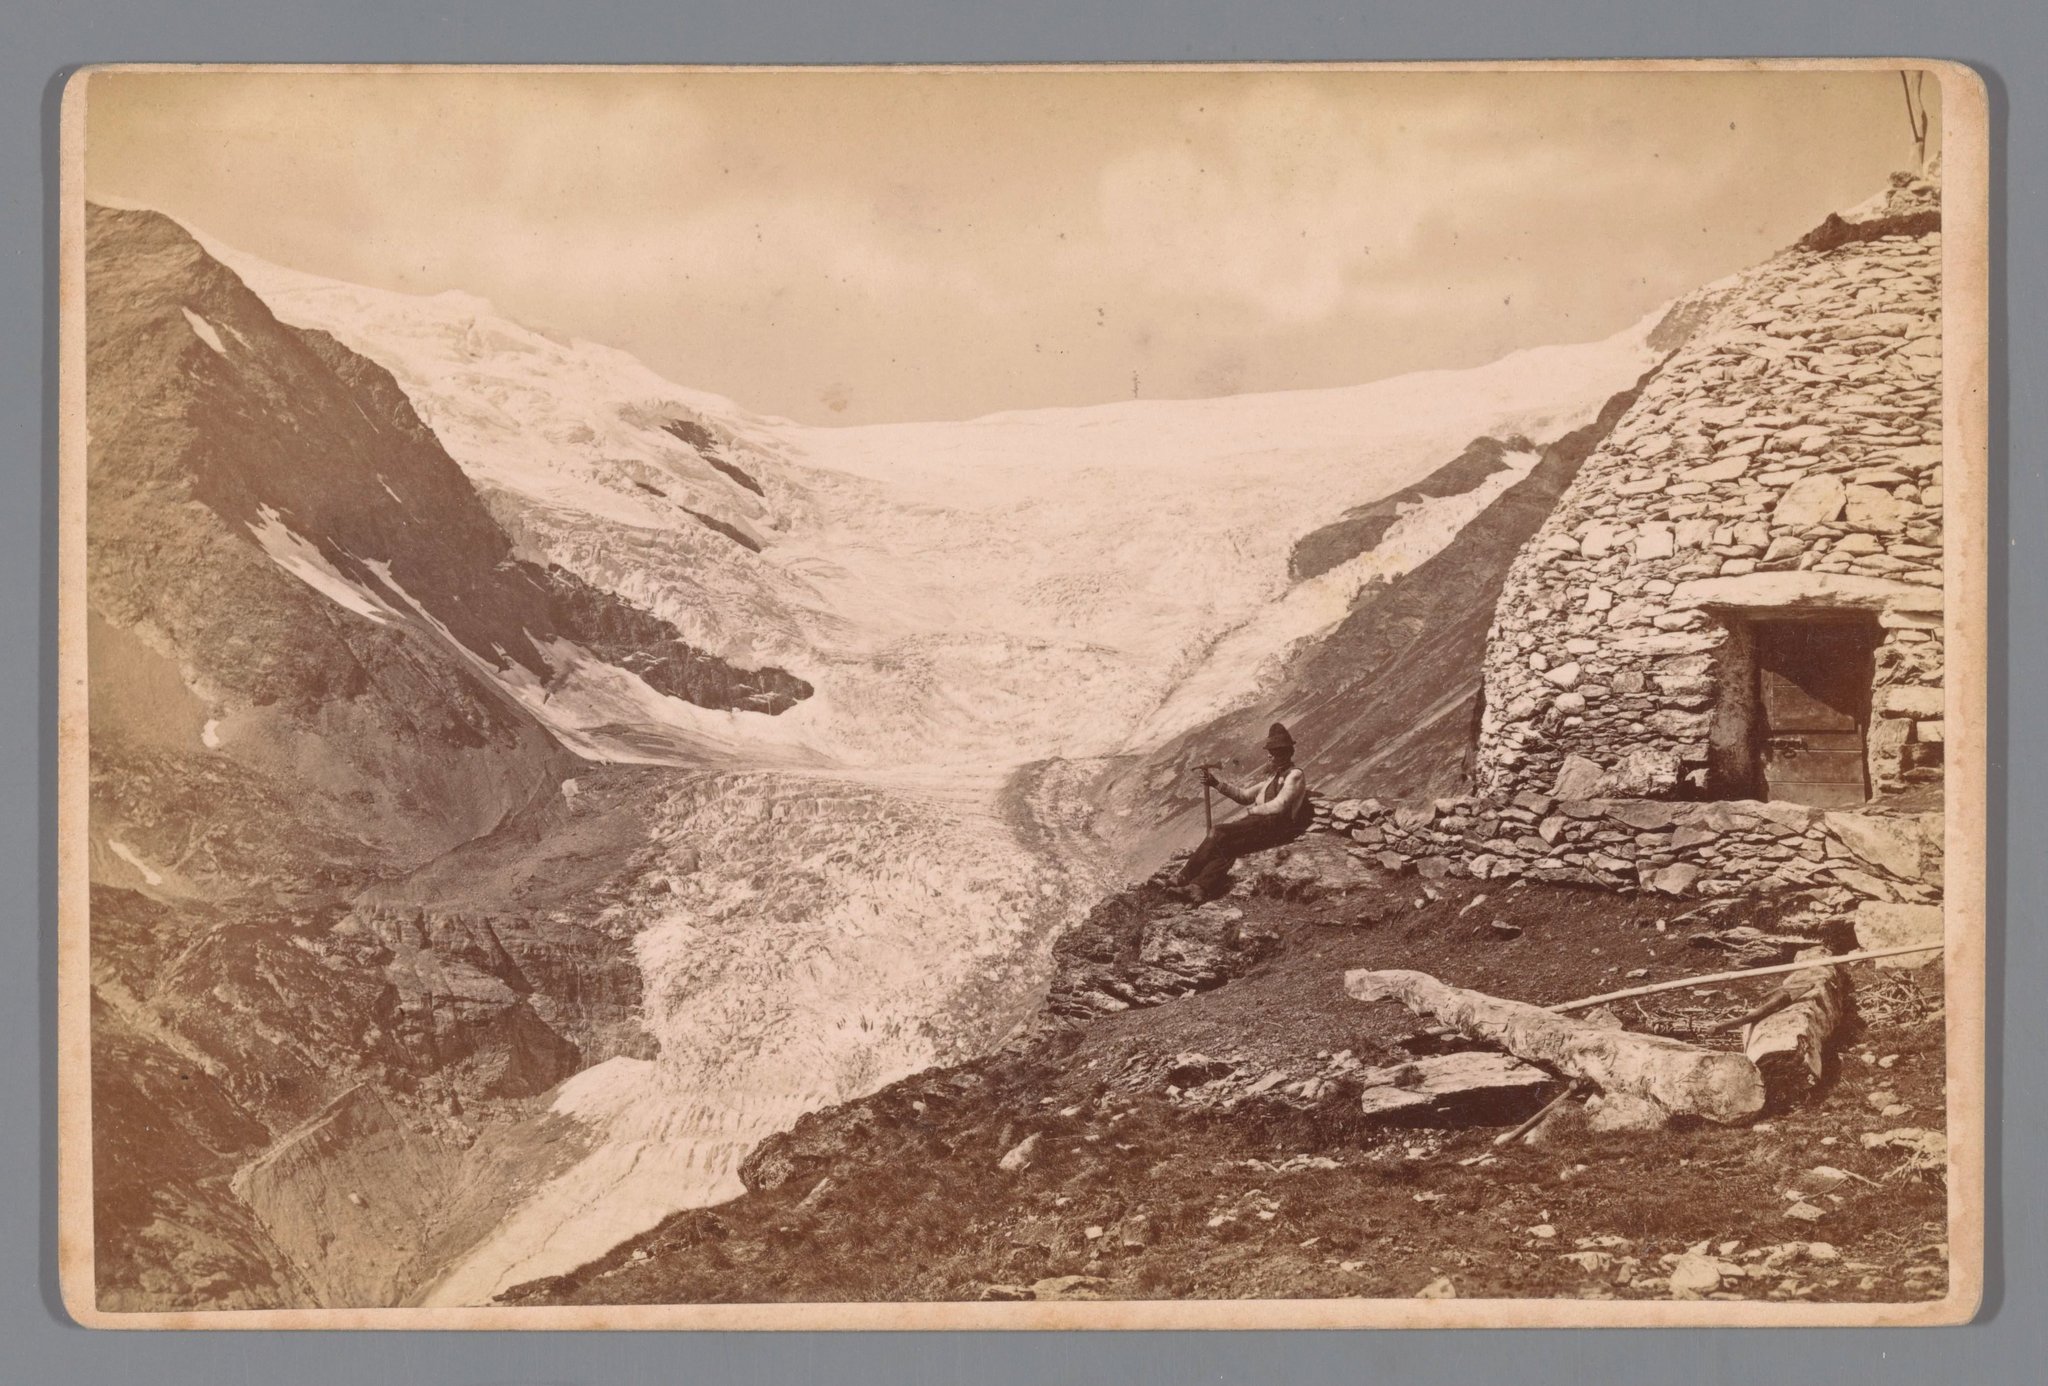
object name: cabinet photograph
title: Palü Gl. von Sassalmason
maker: Anonymous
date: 1875-1885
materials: cardboard, photographic support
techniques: albumen print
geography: switzerland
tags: glacier, switzerland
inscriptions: number: ‘208’